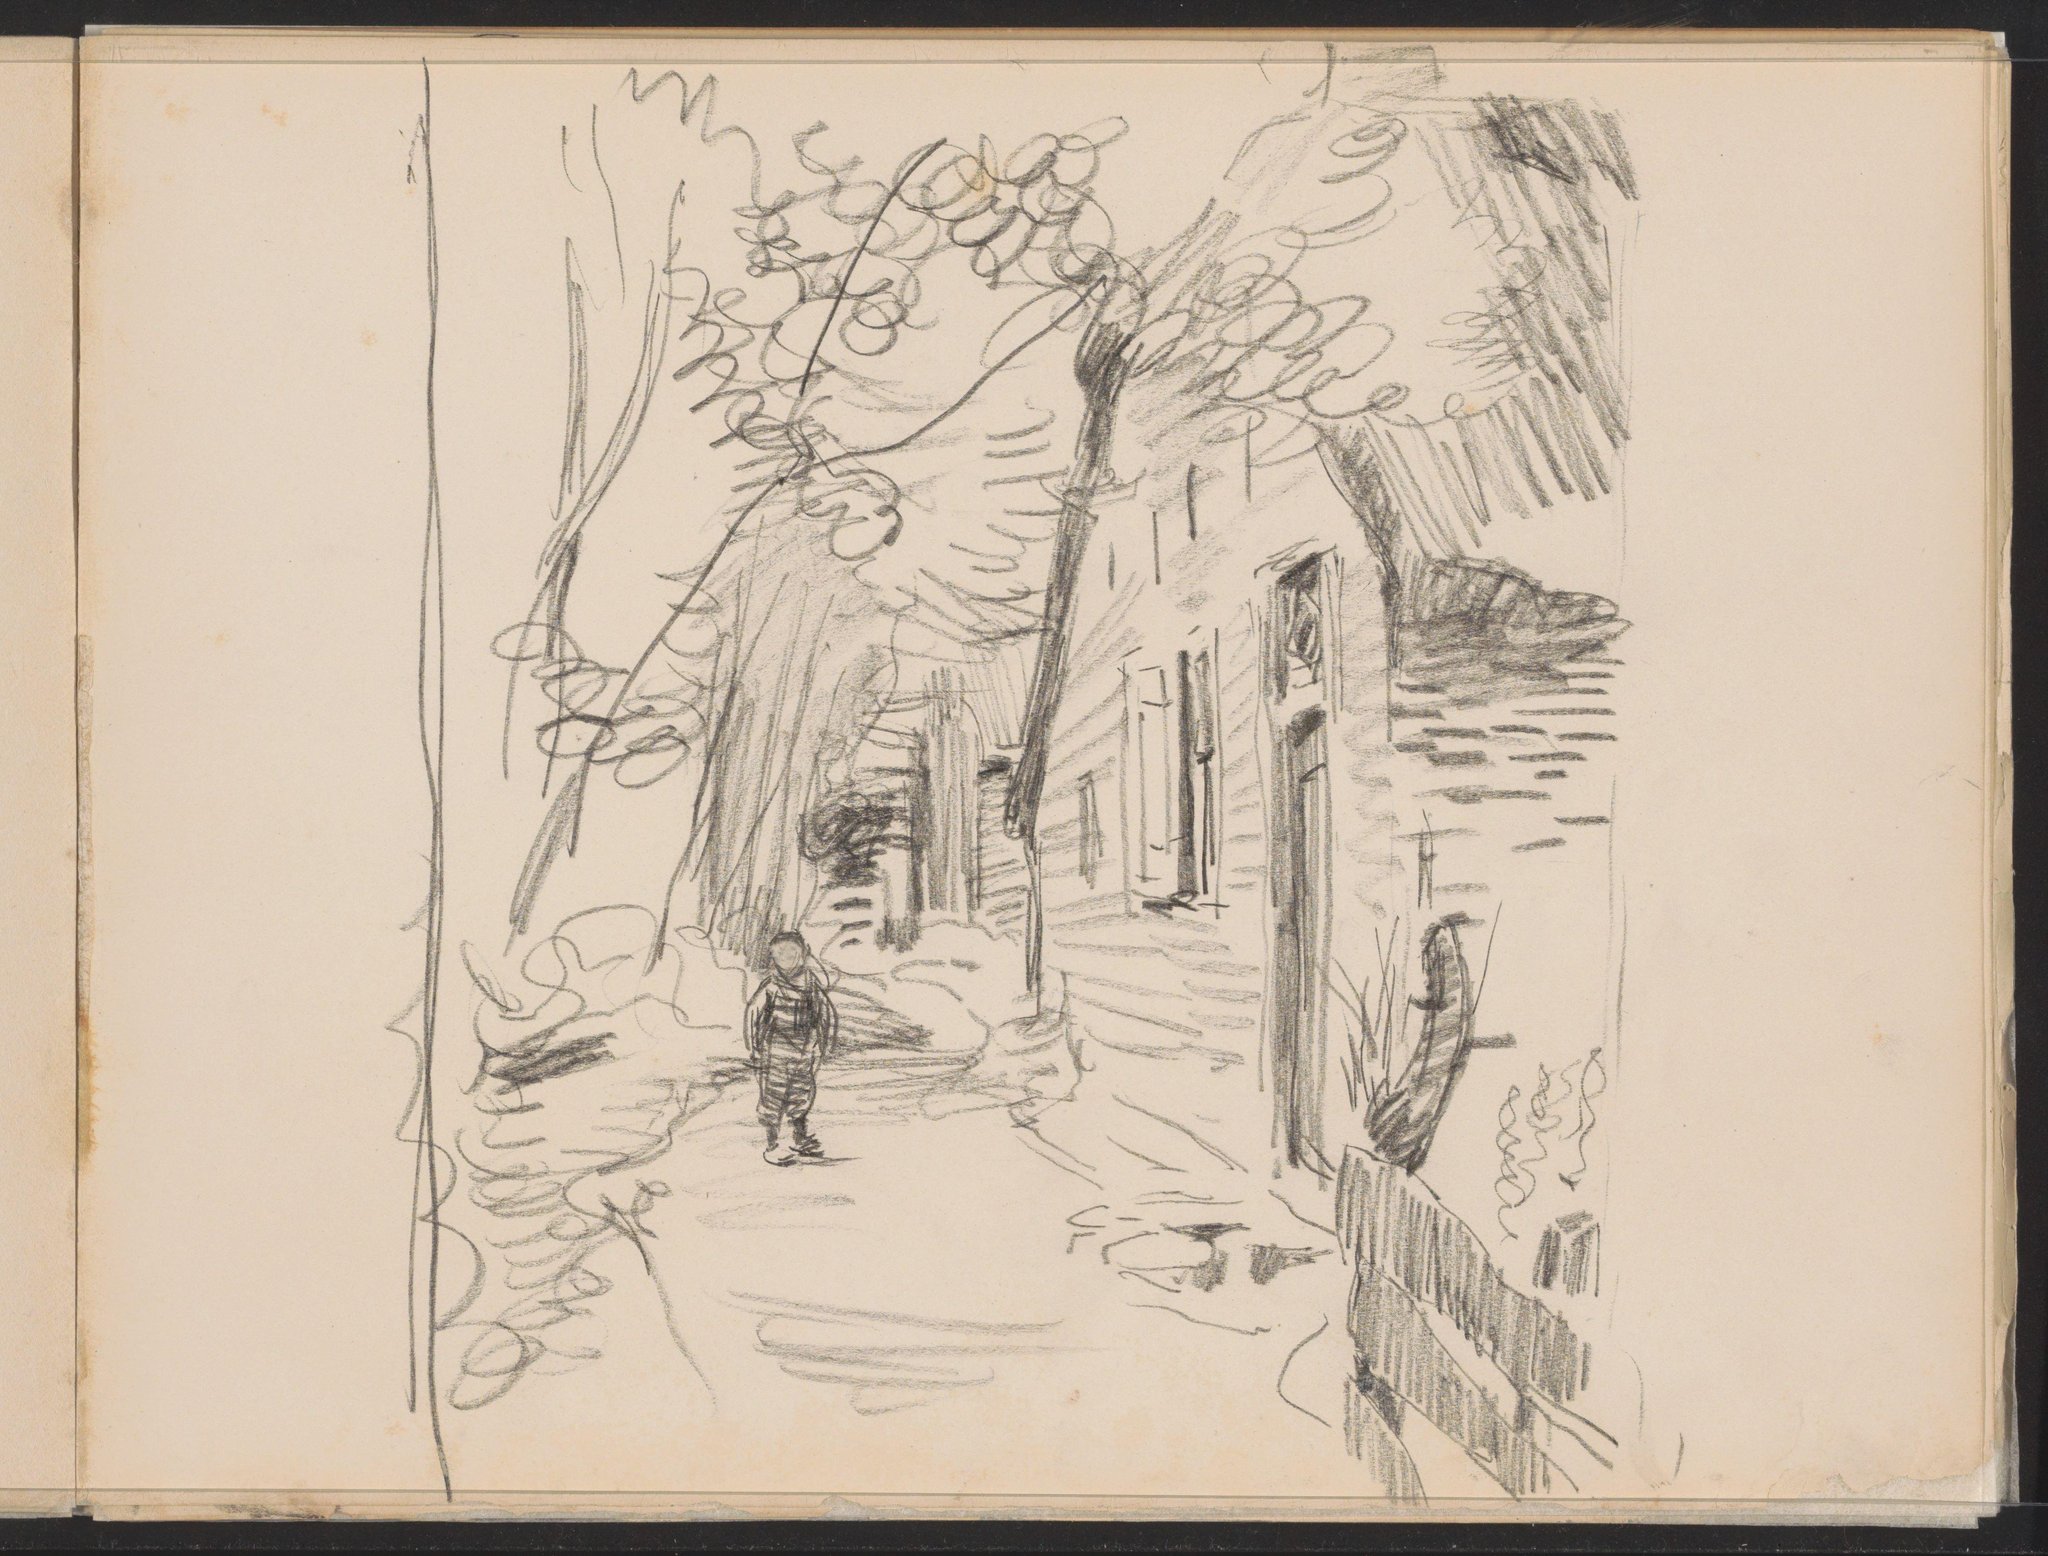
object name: sketchbook leaf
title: Jongen op een weg langs een rij arbeiderswoningen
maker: willem bastiaan tholen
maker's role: draughtsman, painter, print maker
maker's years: 1860-1931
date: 1870-1931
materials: chalk, paper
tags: trees, boy (child between toddler and youth), rural housing, e.g. country-house, villa, cottage, road, path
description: Blad 14 recto uit een schetsboek met 28 bladen.